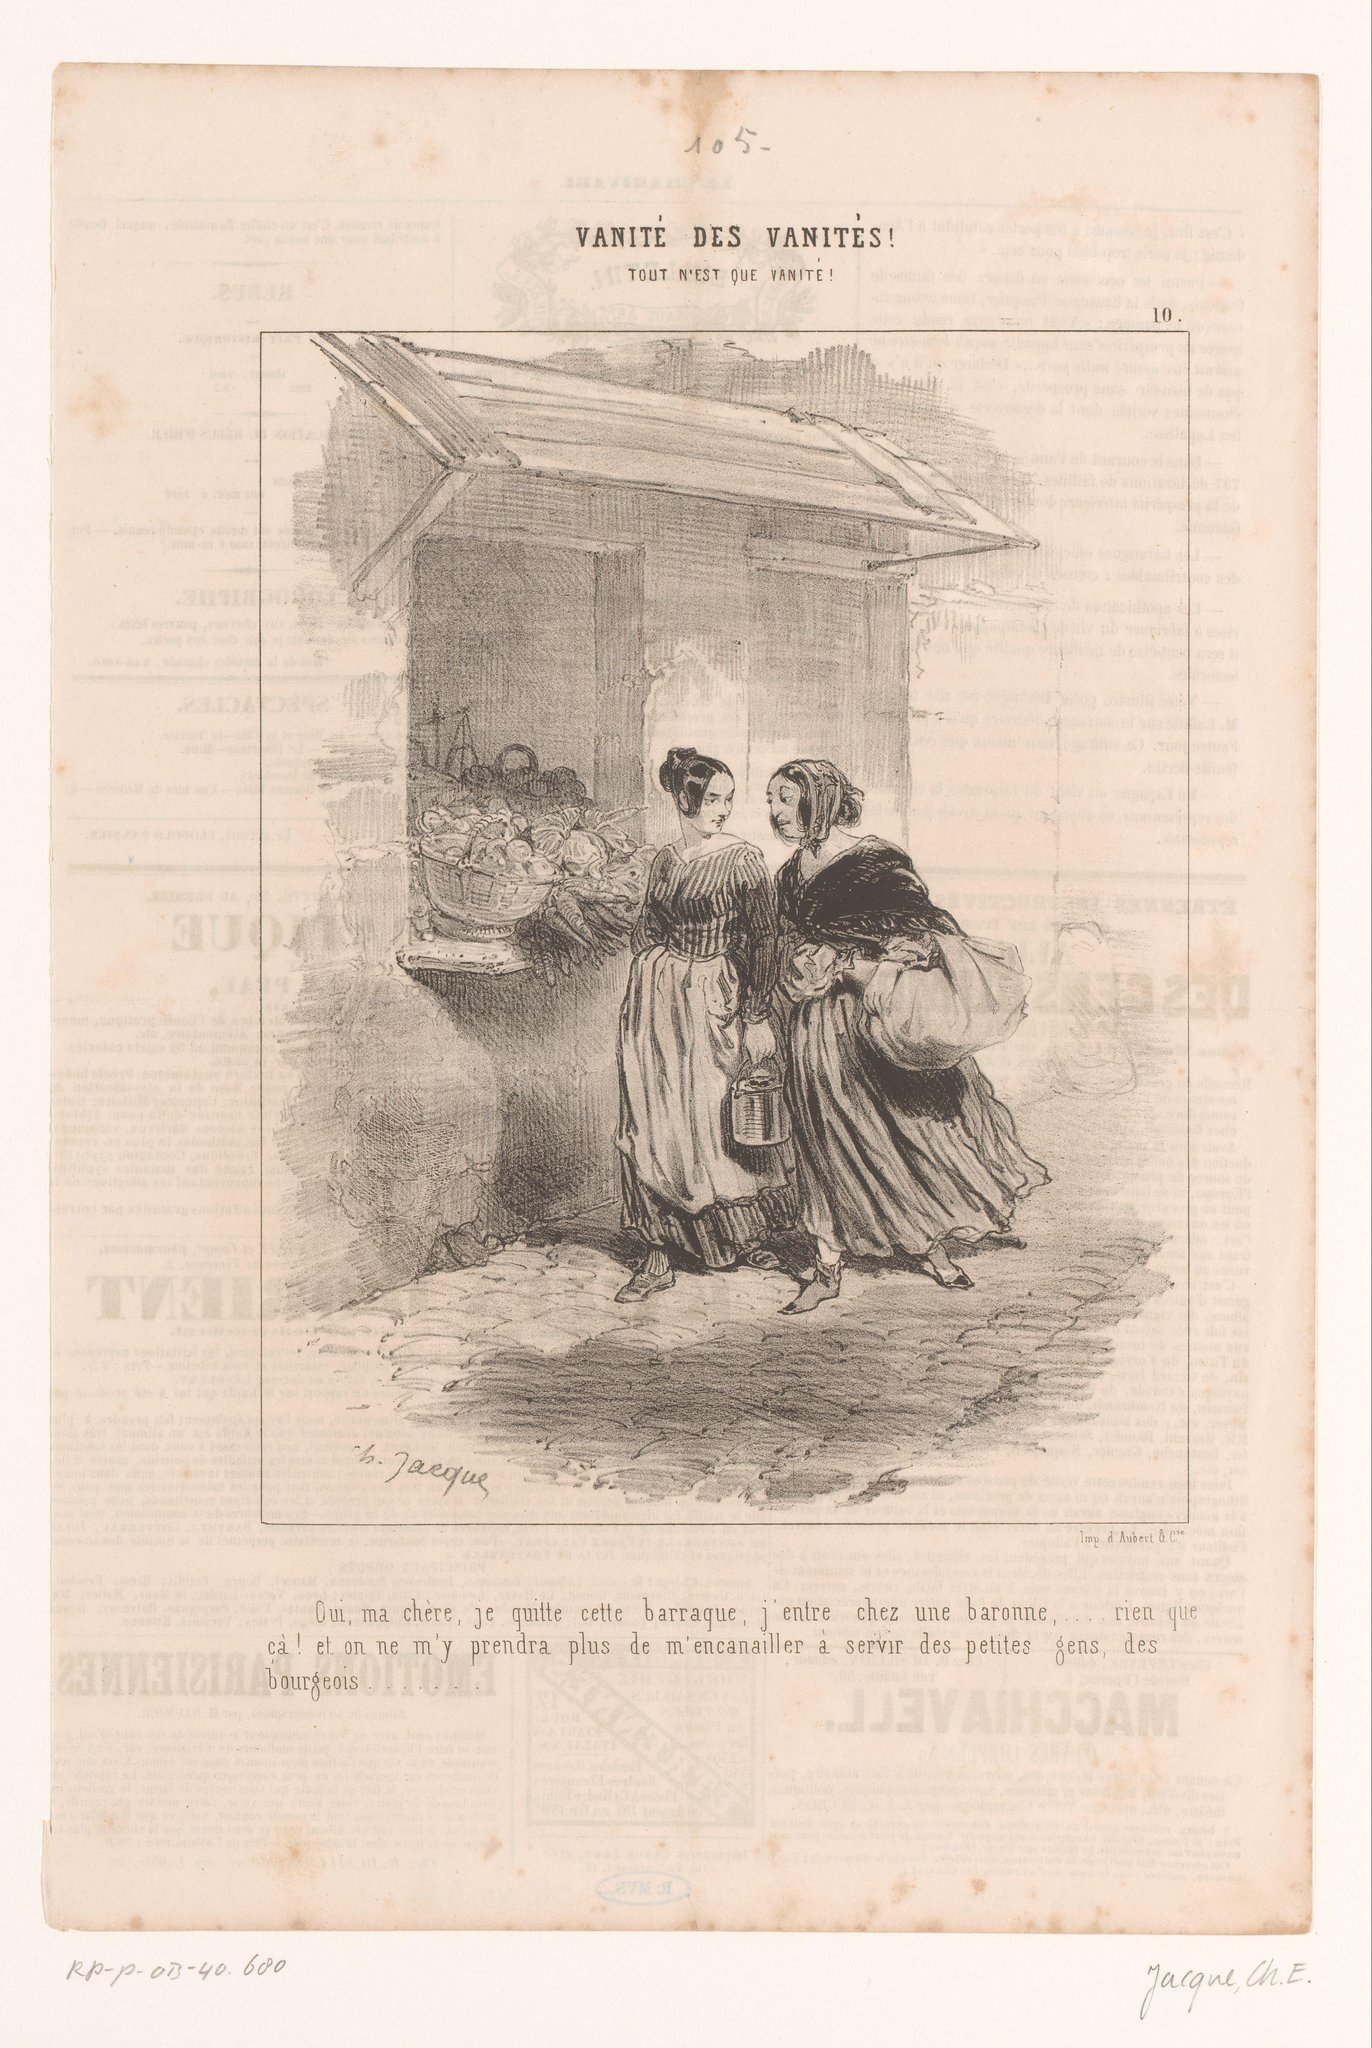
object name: print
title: Twee vrouwen in gesprek op straat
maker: charles emile jacque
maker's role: draughtsman, painter, print maker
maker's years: 1813-1894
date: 1843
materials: paper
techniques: lithograph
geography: paris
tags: walking - aa - female human figure, conversation, dialogue; conversation piece, street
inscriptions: collector's mark: Lugt 2228a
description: Prent gebruikt voor: Le Charivari, 1843.